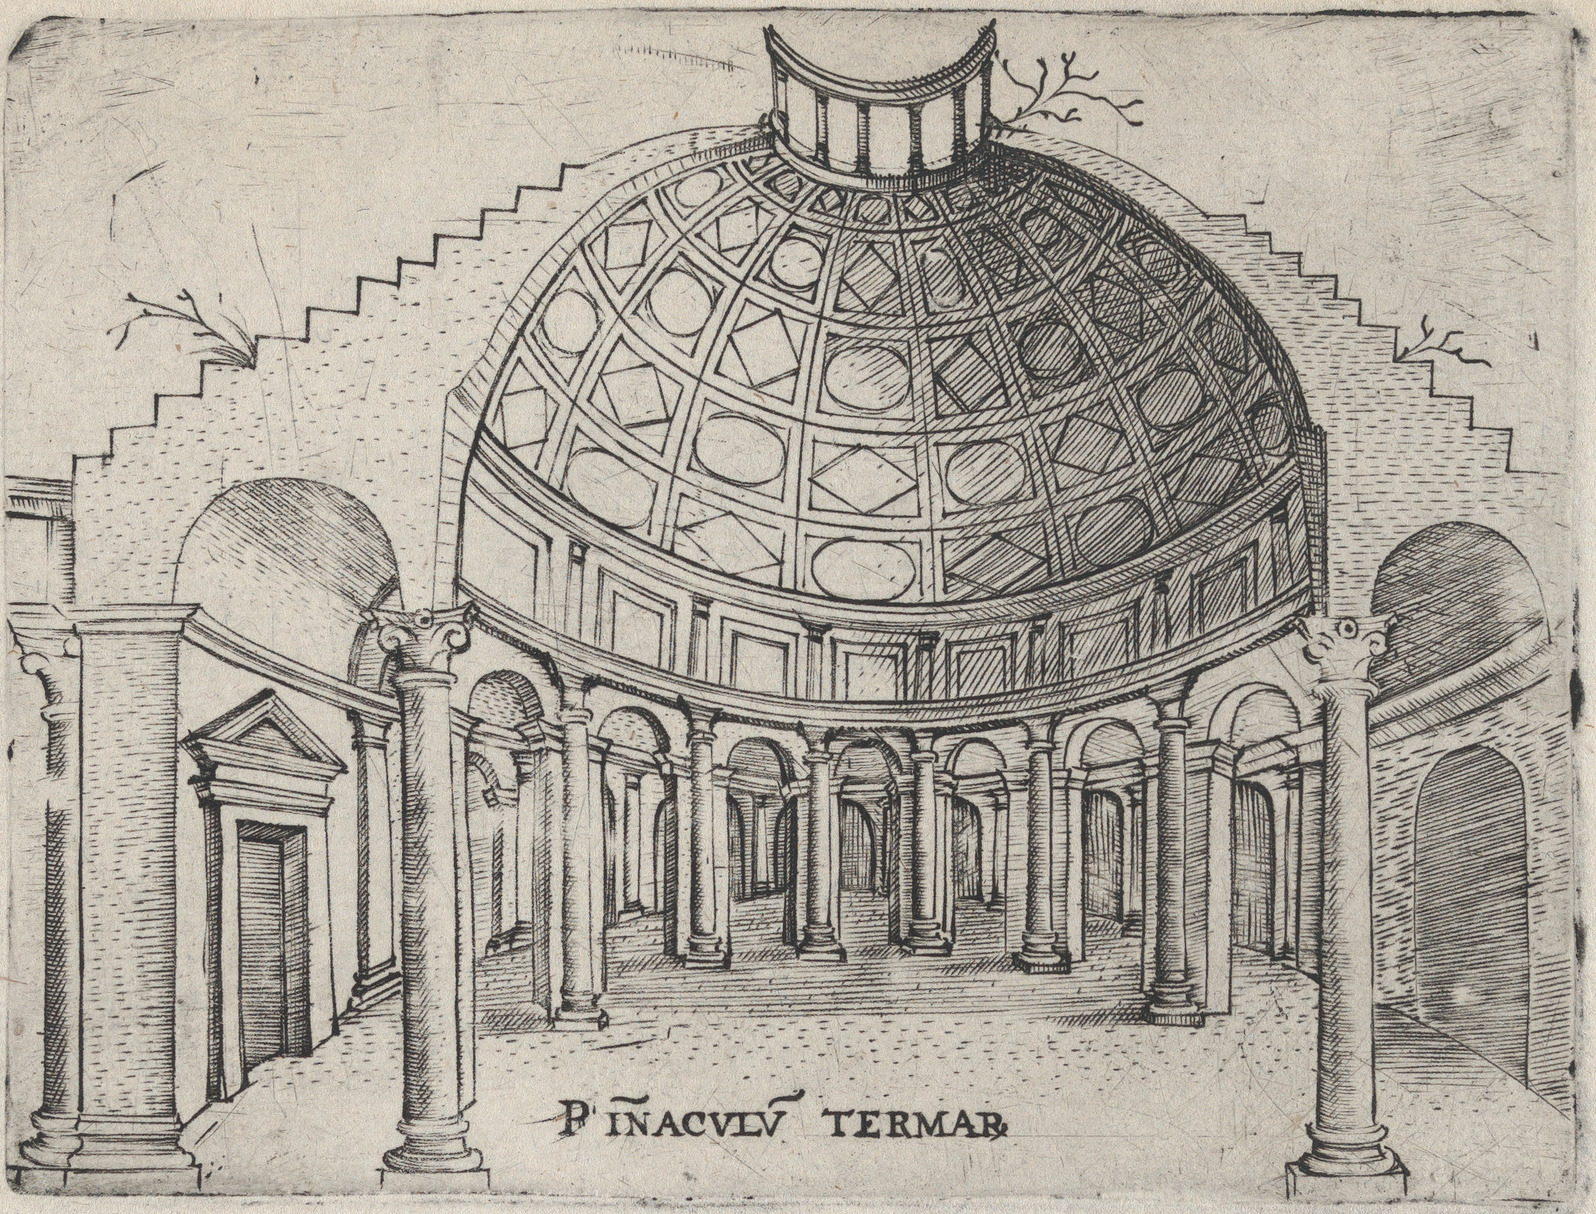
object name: print ornament architecture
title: Pinaculu Termar (sic), from a Series of 24 Depicting (Reconstructed) Buildings from Roman Antiquity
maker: anonymous, italian, 16th century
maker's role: artist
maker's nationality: italian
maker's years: 1500-1600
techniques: engraving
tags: architecture